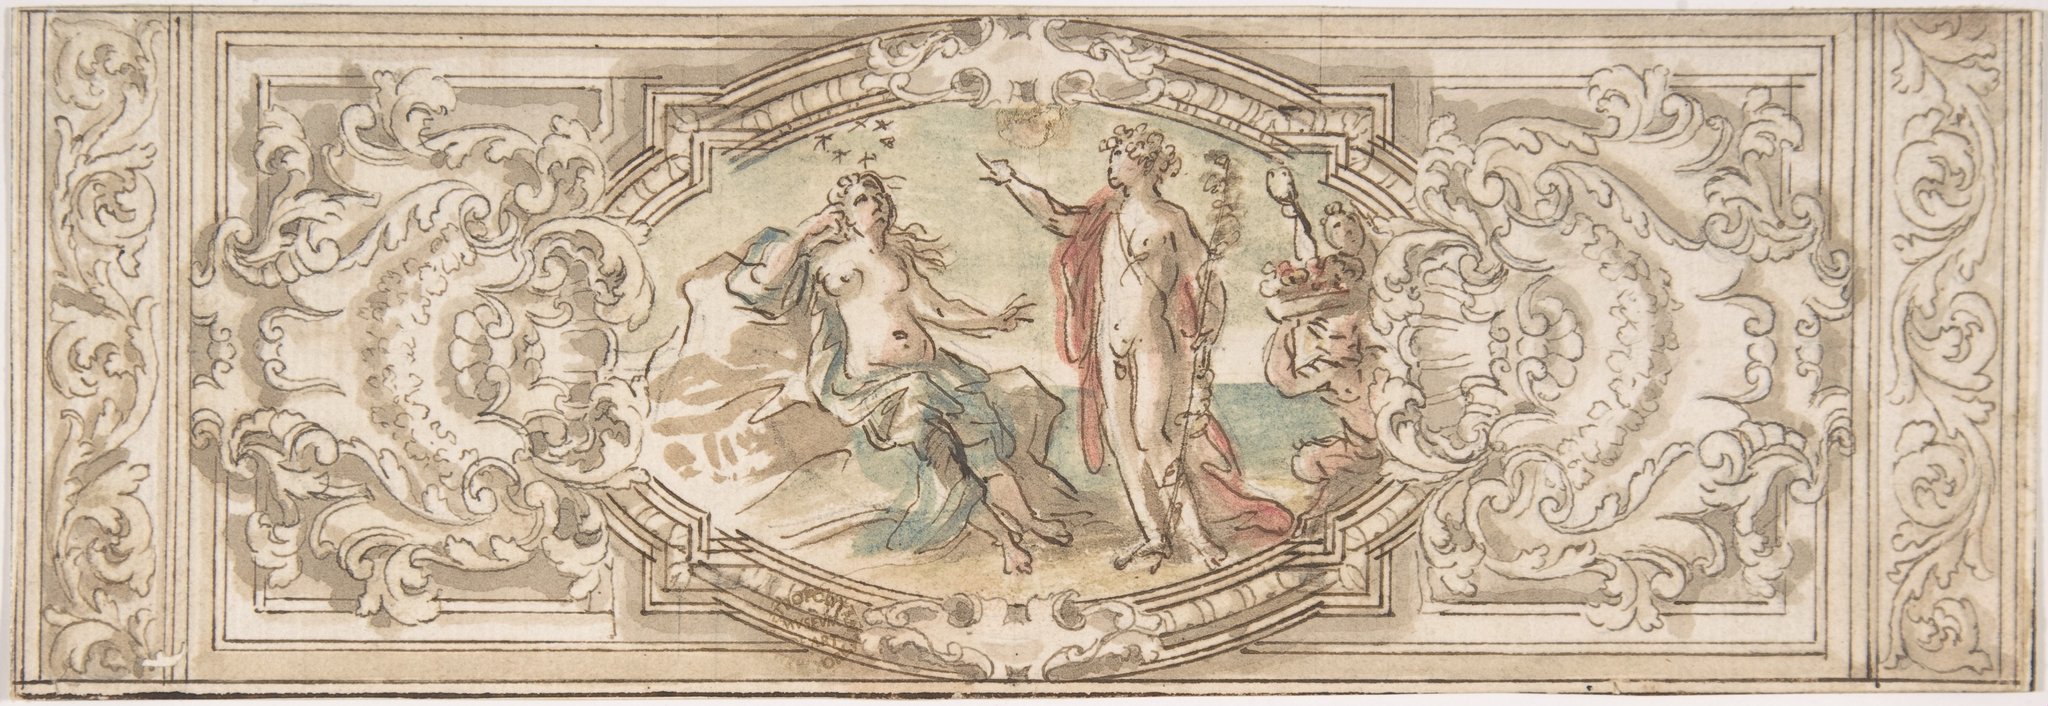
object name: drawing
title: Design for a Panel with a Depiction of Bacchus and Ariadne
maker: anonymous, italian, roman-bolognese, 17th century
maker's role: artist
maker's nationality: italian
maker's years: 1600-1700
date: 1601-1700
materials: chalk, ink, paper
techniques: brush, pen, wash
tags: ariadne,bacchus